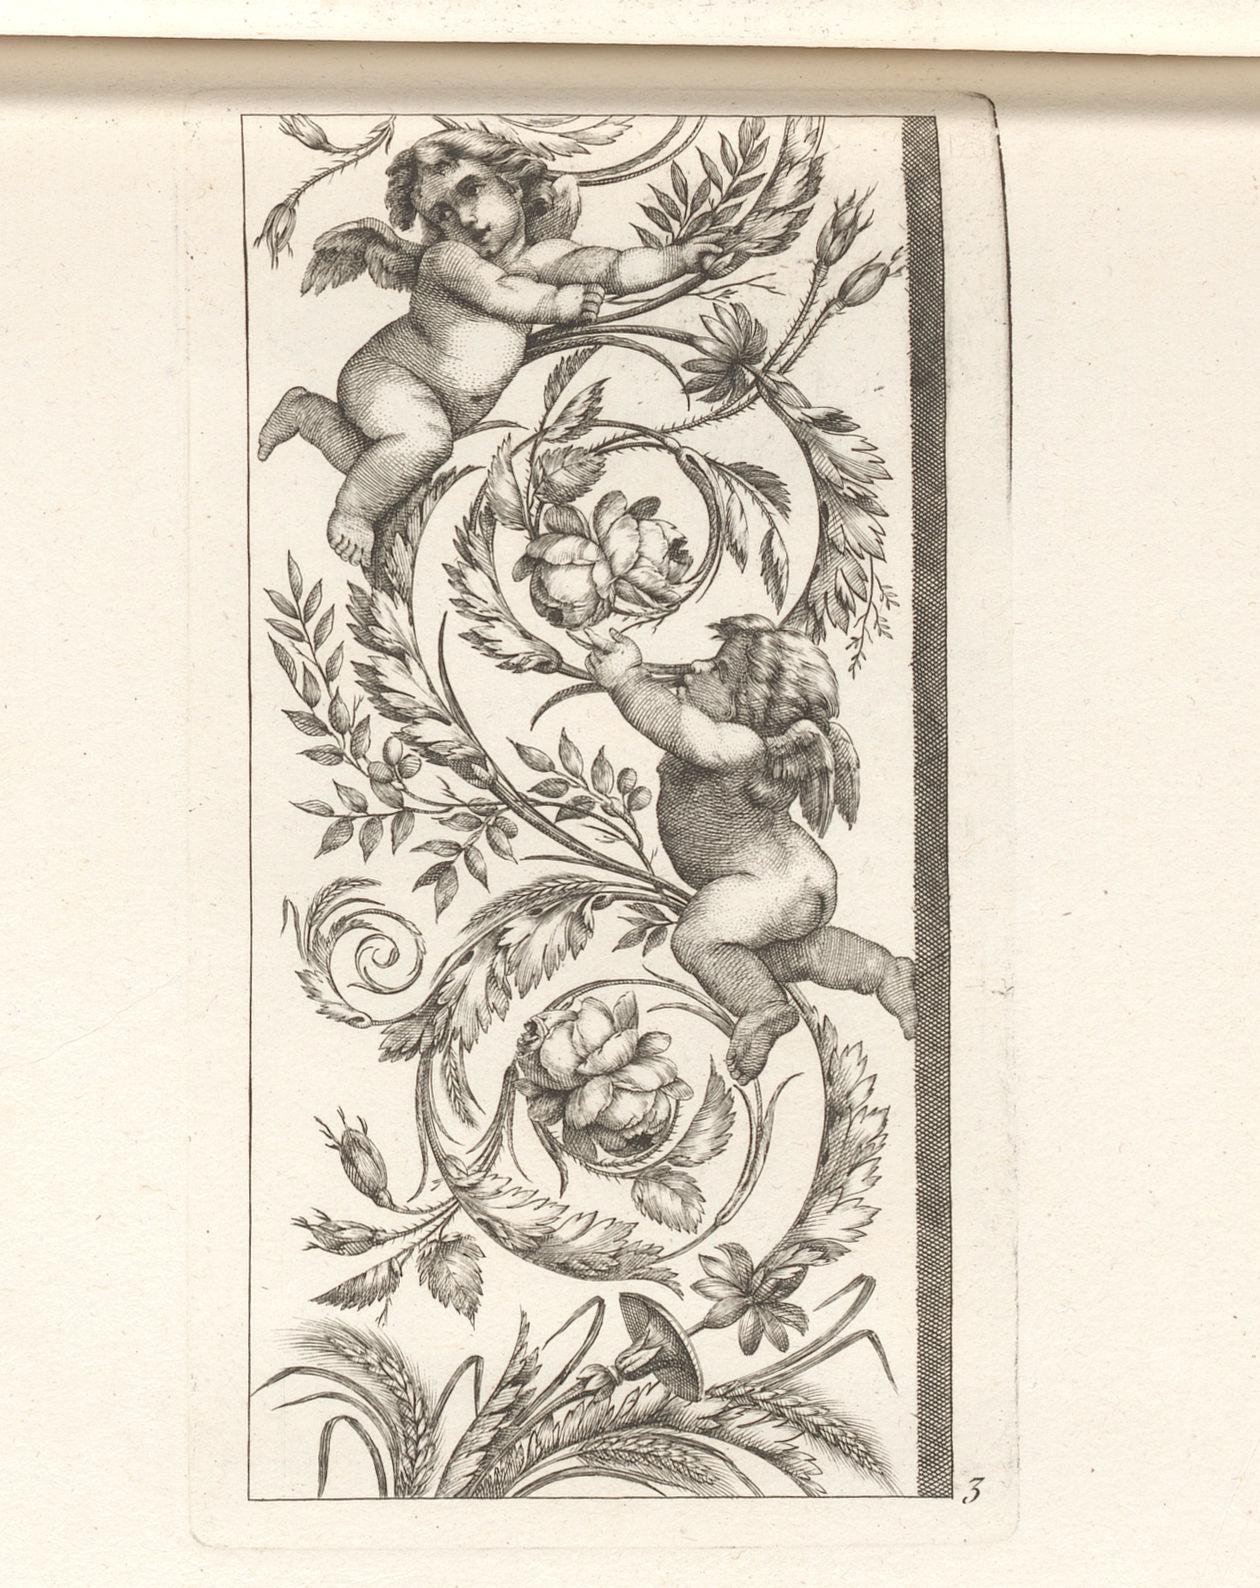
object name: print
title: Ornament met putti en pioenrozen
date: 1802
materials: paper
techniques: engraving, etching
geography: paris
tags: ornament ~ arabesque, plants and herbs: peony, cupids: 'amores', 'amoretti', 'putti', ornament derived from plant forms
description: Doordat dit album bestaat uit meerdere, deels eerder uitgegeven prentreeksen, is de datering niet consequent. Het geheel is op de titelpagina gedateerd op 1802. Deze reeks is niet afzonderlijk gedateerd. De serietitel voor het gehele werk is "Recueil d'arabesques, contenant les loges du Vatican". De andere serietitel is de titel van de specifieke reeks binnen het geheel.